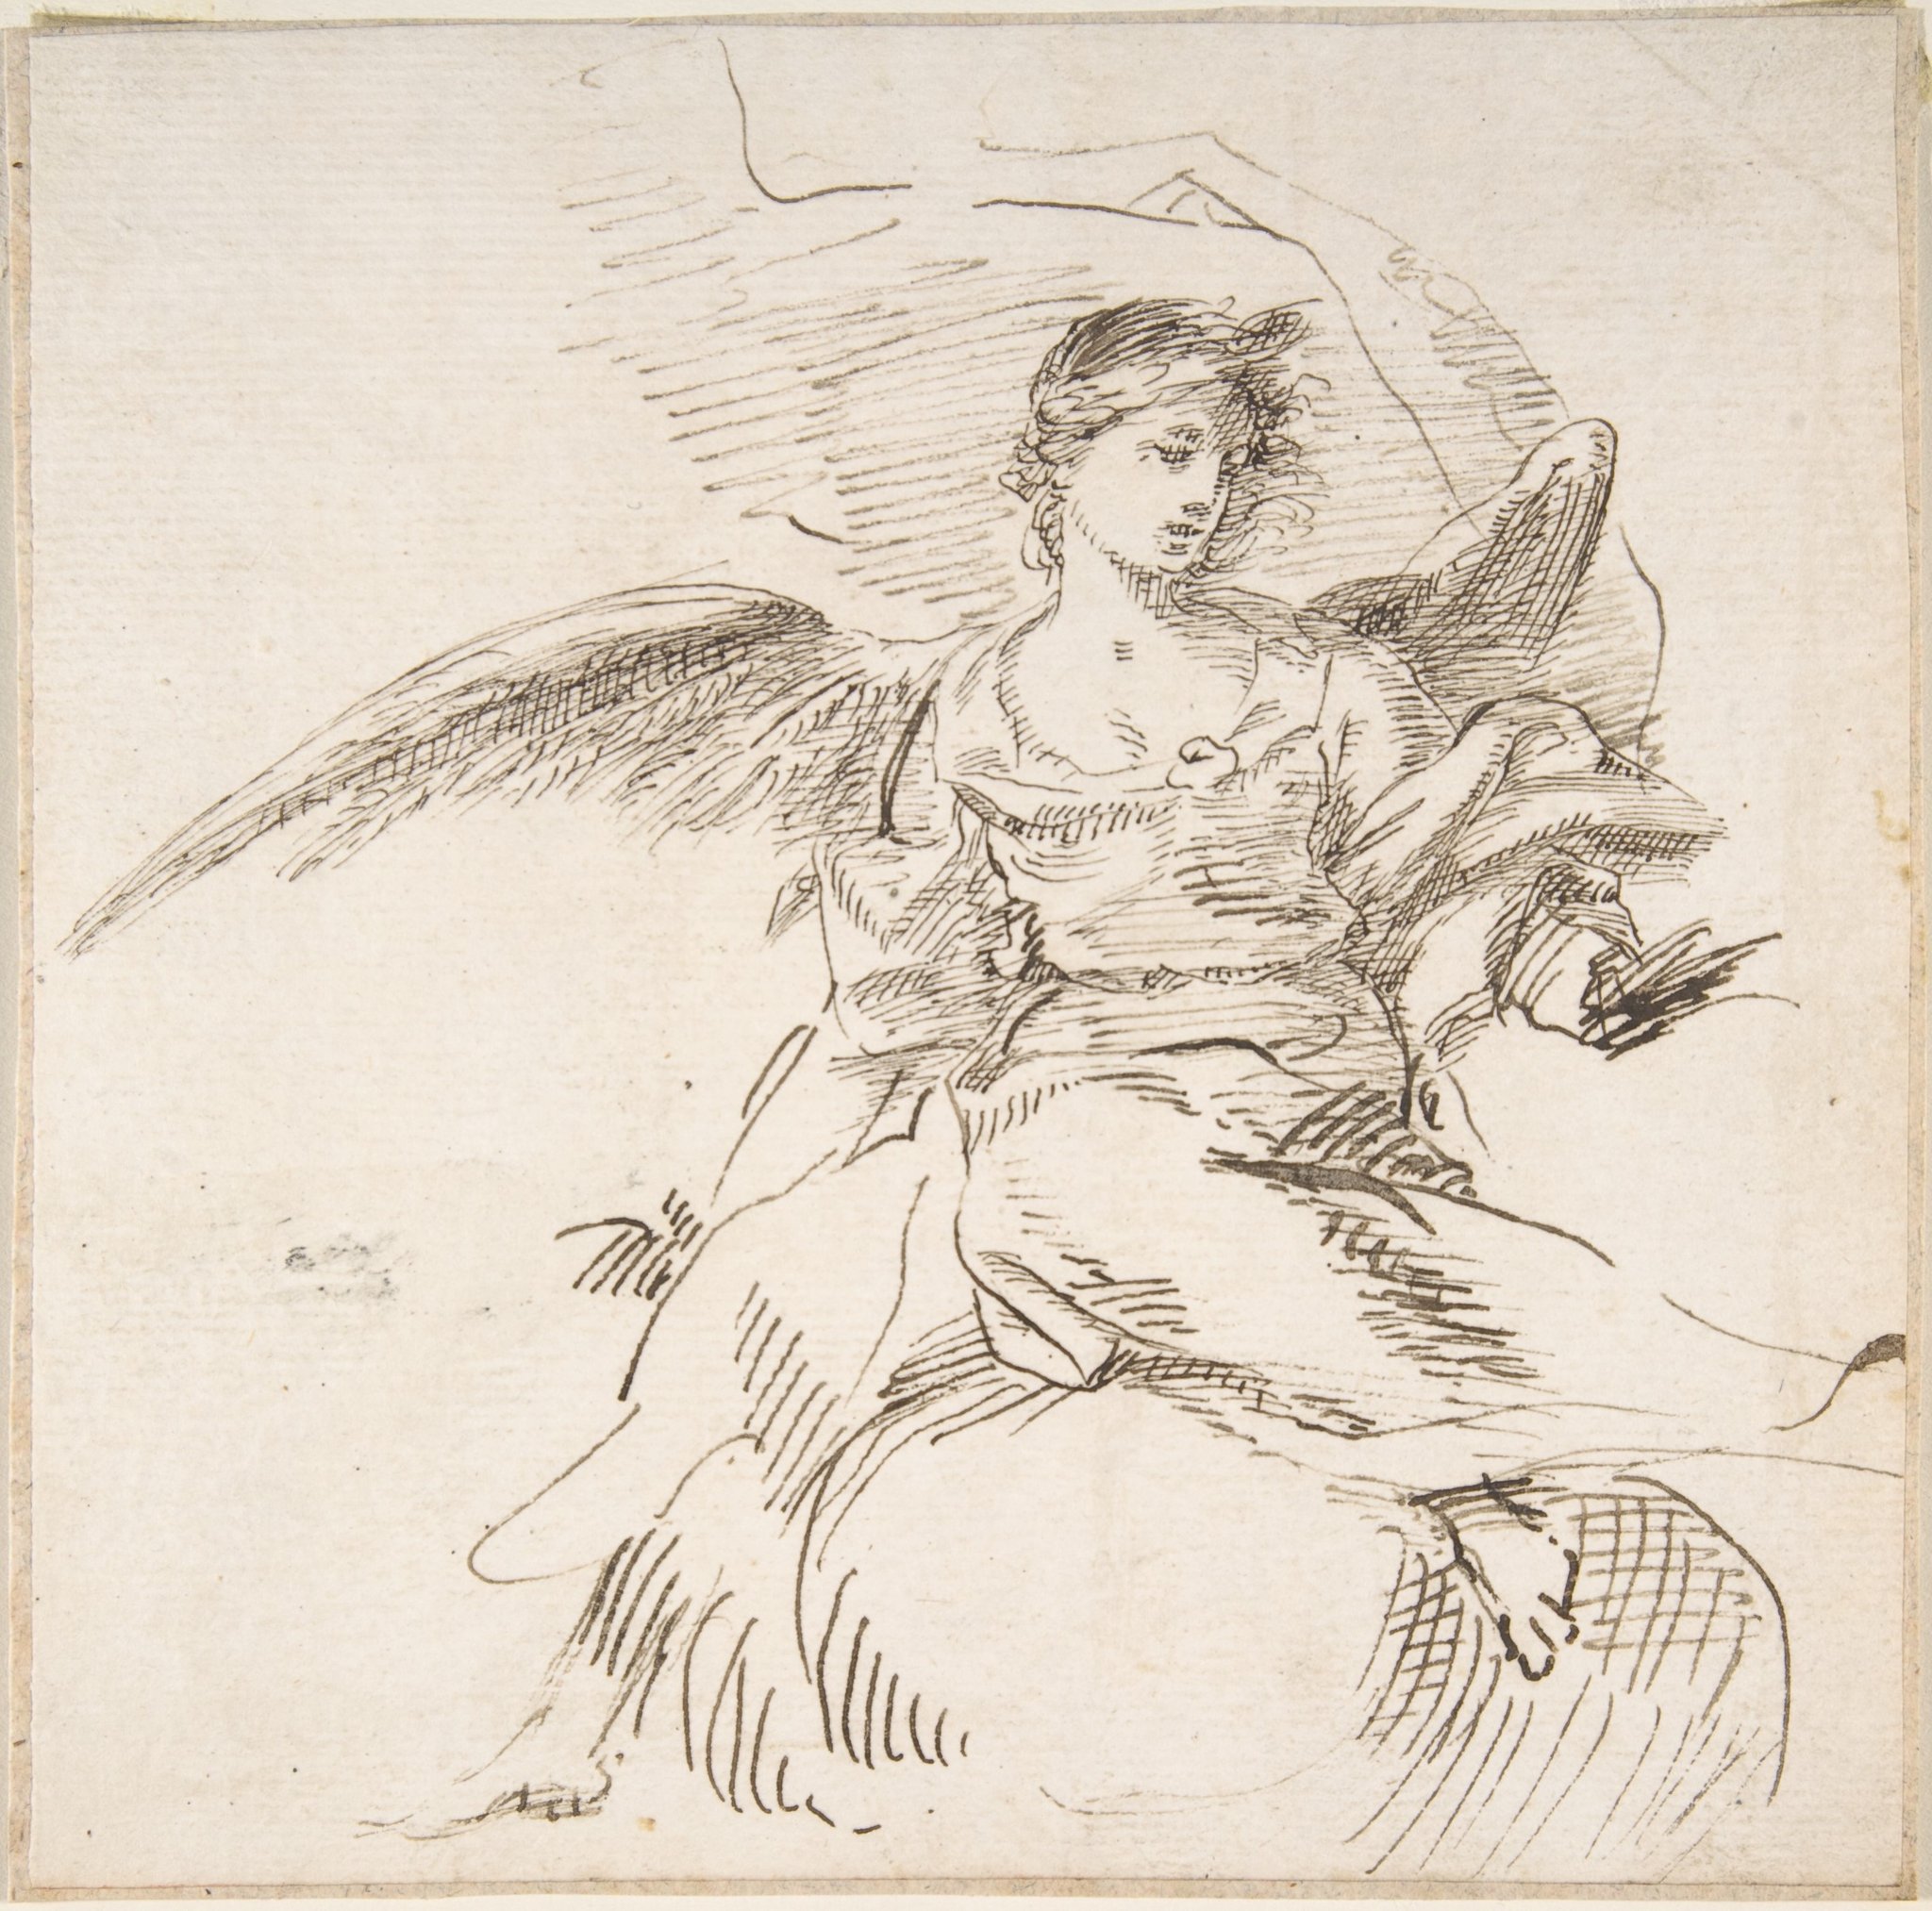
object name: drawing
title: Angel Seated on Clouds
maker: pedro duque cornejo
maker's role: artist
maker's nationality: spanish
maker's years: 1677-1757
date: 1700-1750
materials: ink, paper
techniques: pen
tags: angels